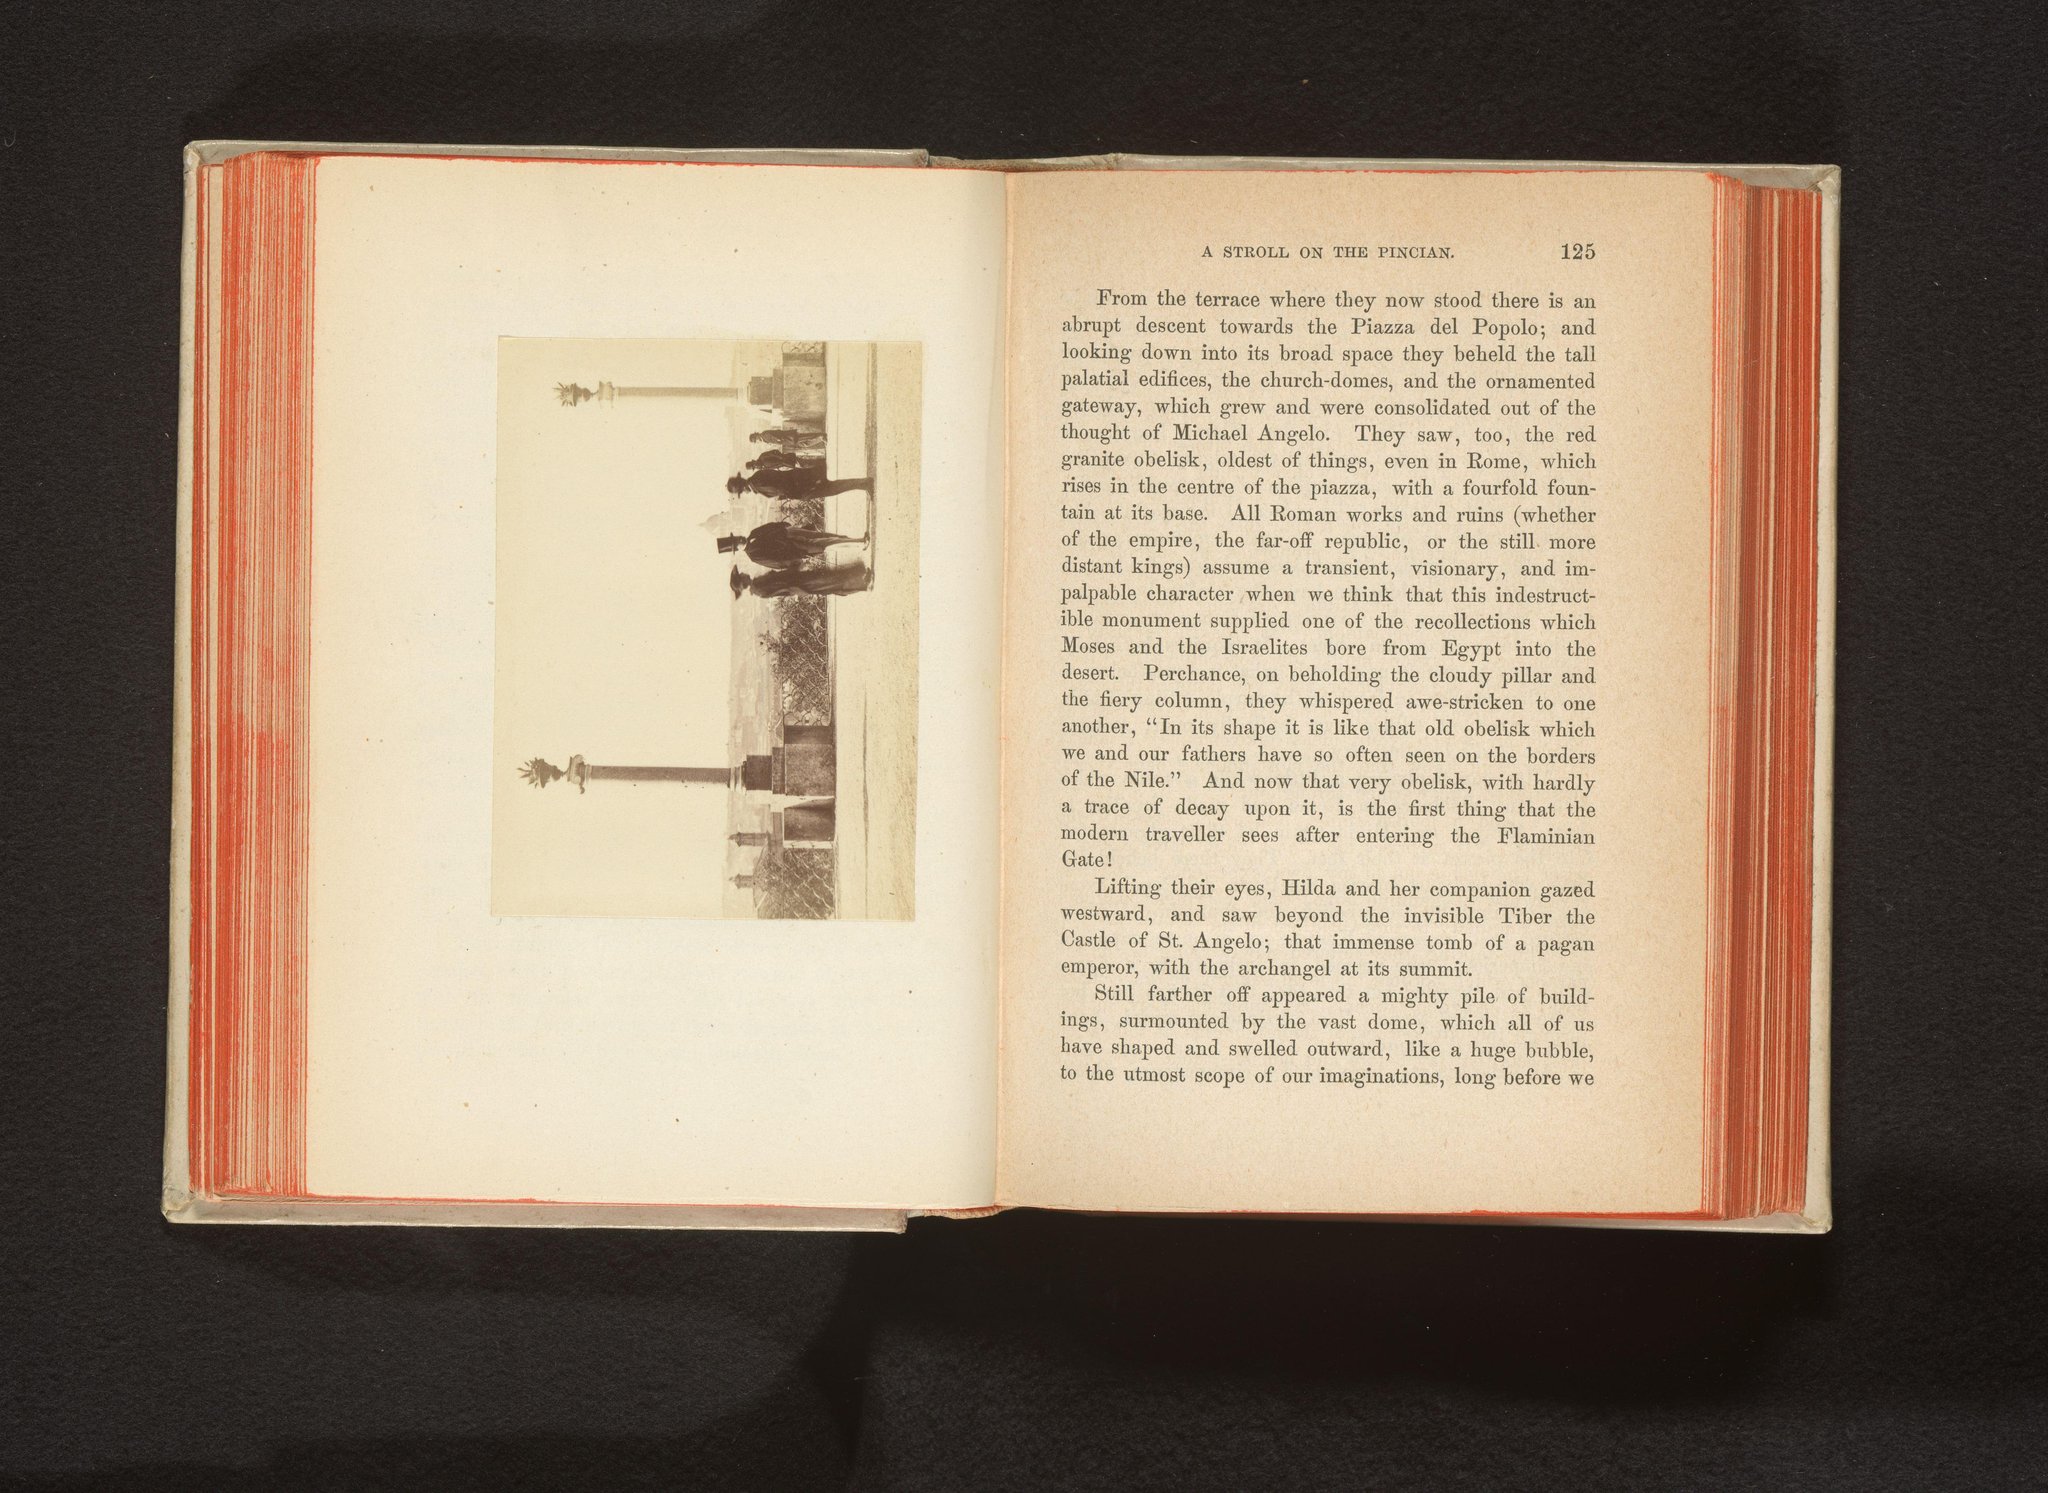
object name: page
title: Gezicht op een terras in de Giardino del Pincio in Rome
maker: Anonymous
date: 1850-1860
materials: photographic support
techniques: albumen print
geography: pincio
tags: prospect of city, town panorama, silhouette of city